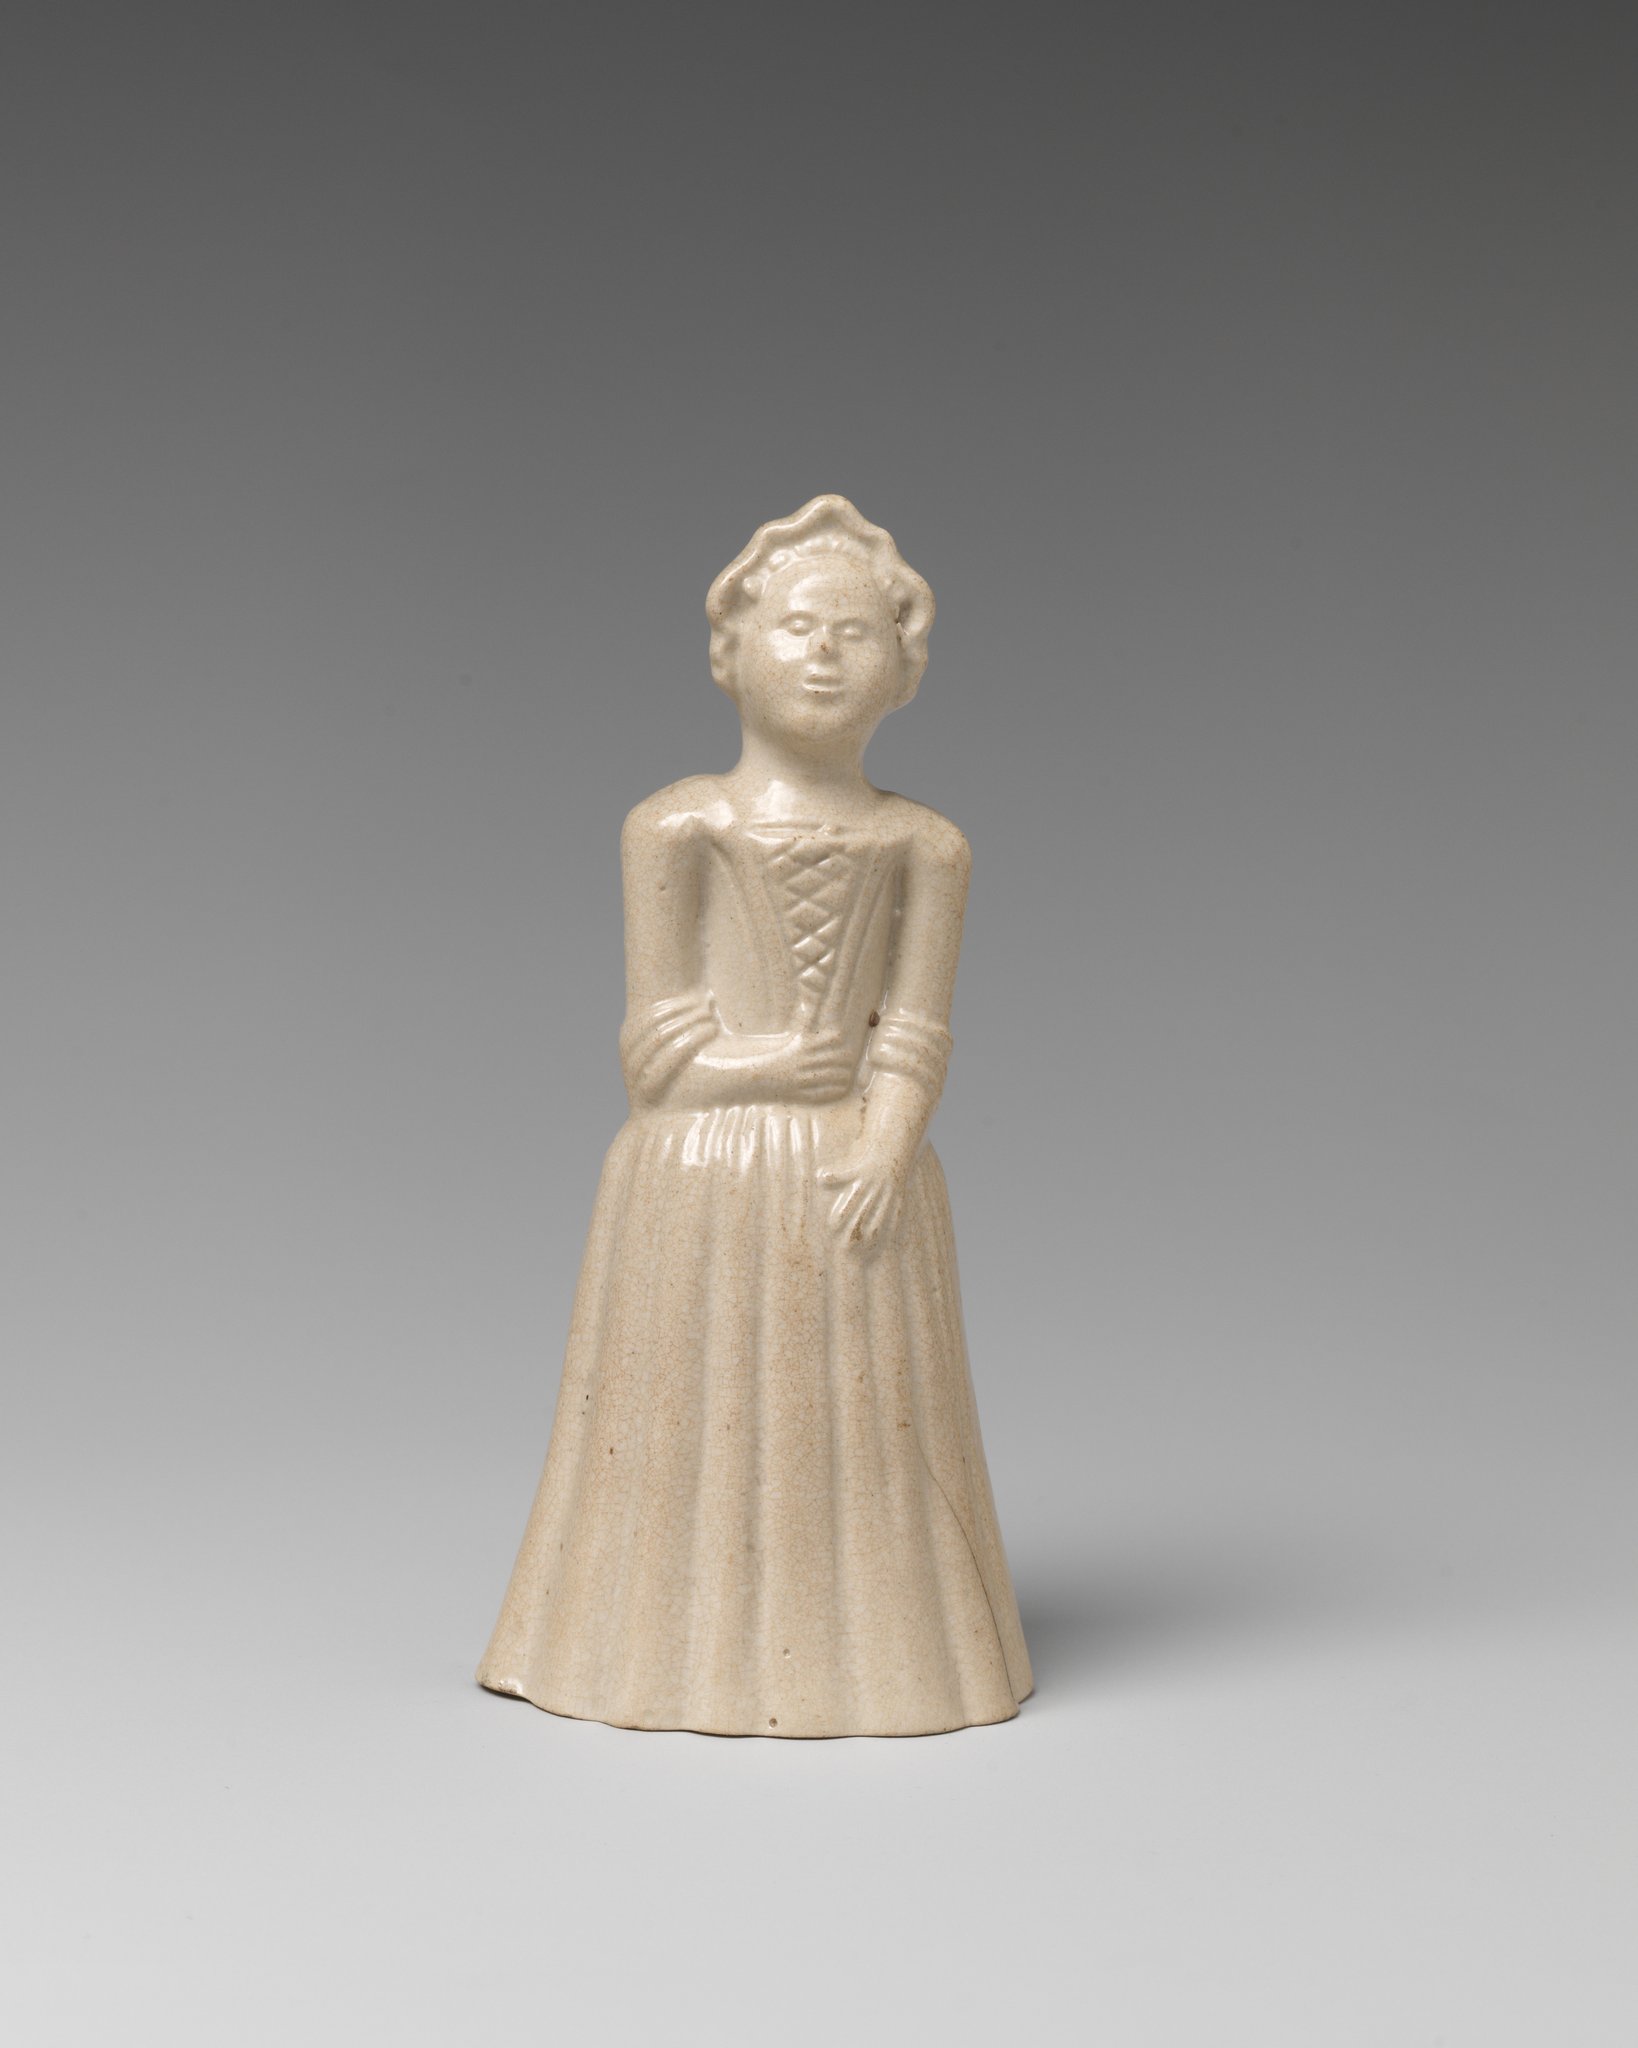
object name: figure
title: Figure of a woman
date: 1745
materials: stoneware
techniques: salt glaze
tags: women